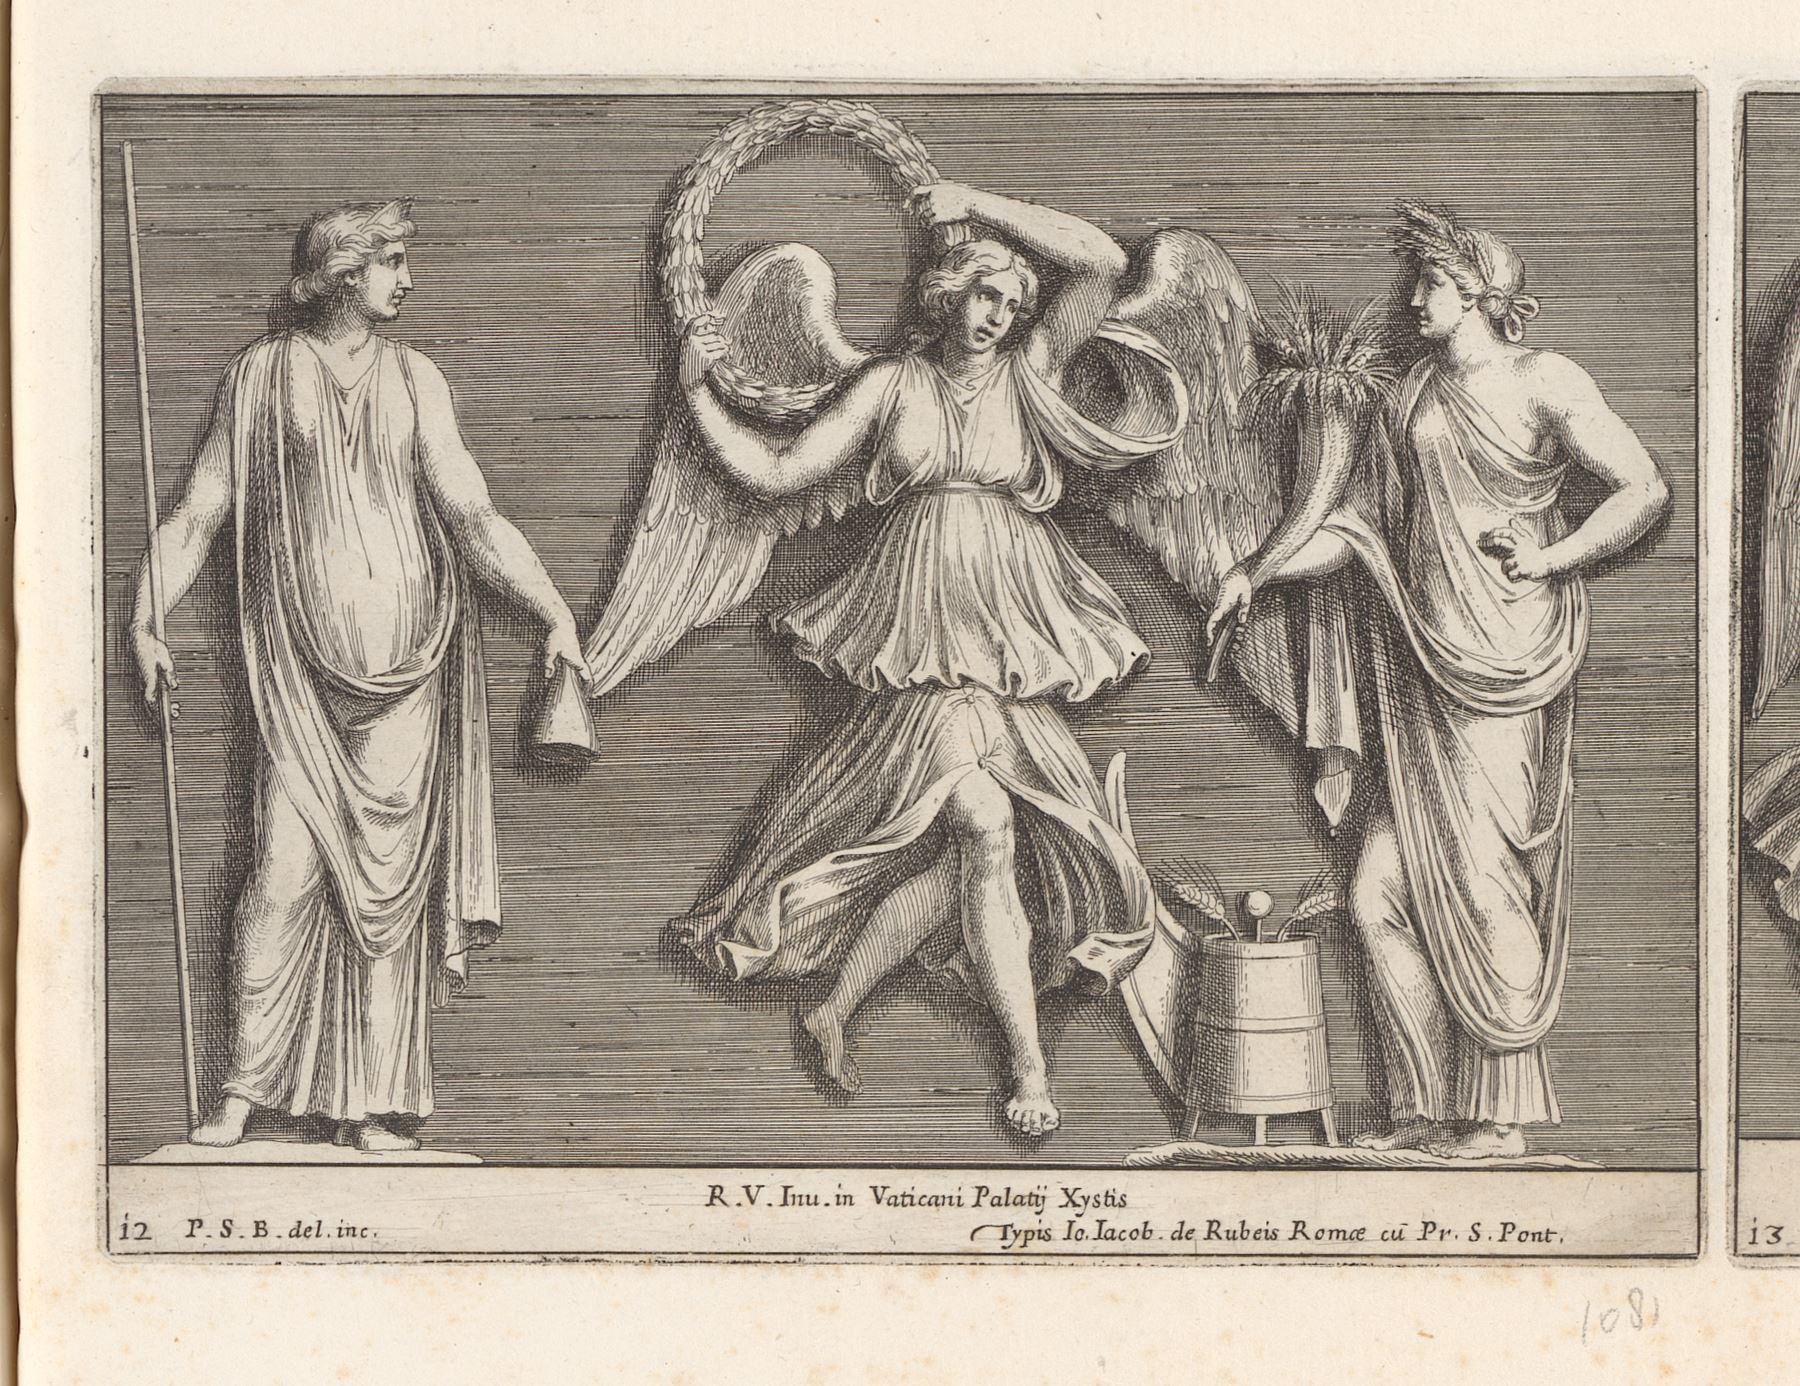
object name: print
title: Twee vrouwen en een engel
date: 1645-1700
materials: paper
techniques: engraving, etching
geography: vatican city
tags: adult woman, angels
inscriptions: number: ‘42’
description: Twee vrouwen in toga's, de linker met een staf en de rechter met een hoorn en emmer met graan, kijken naar een engel met krans (Victorie?) in het midden. Prent maakt deel uit van een album.